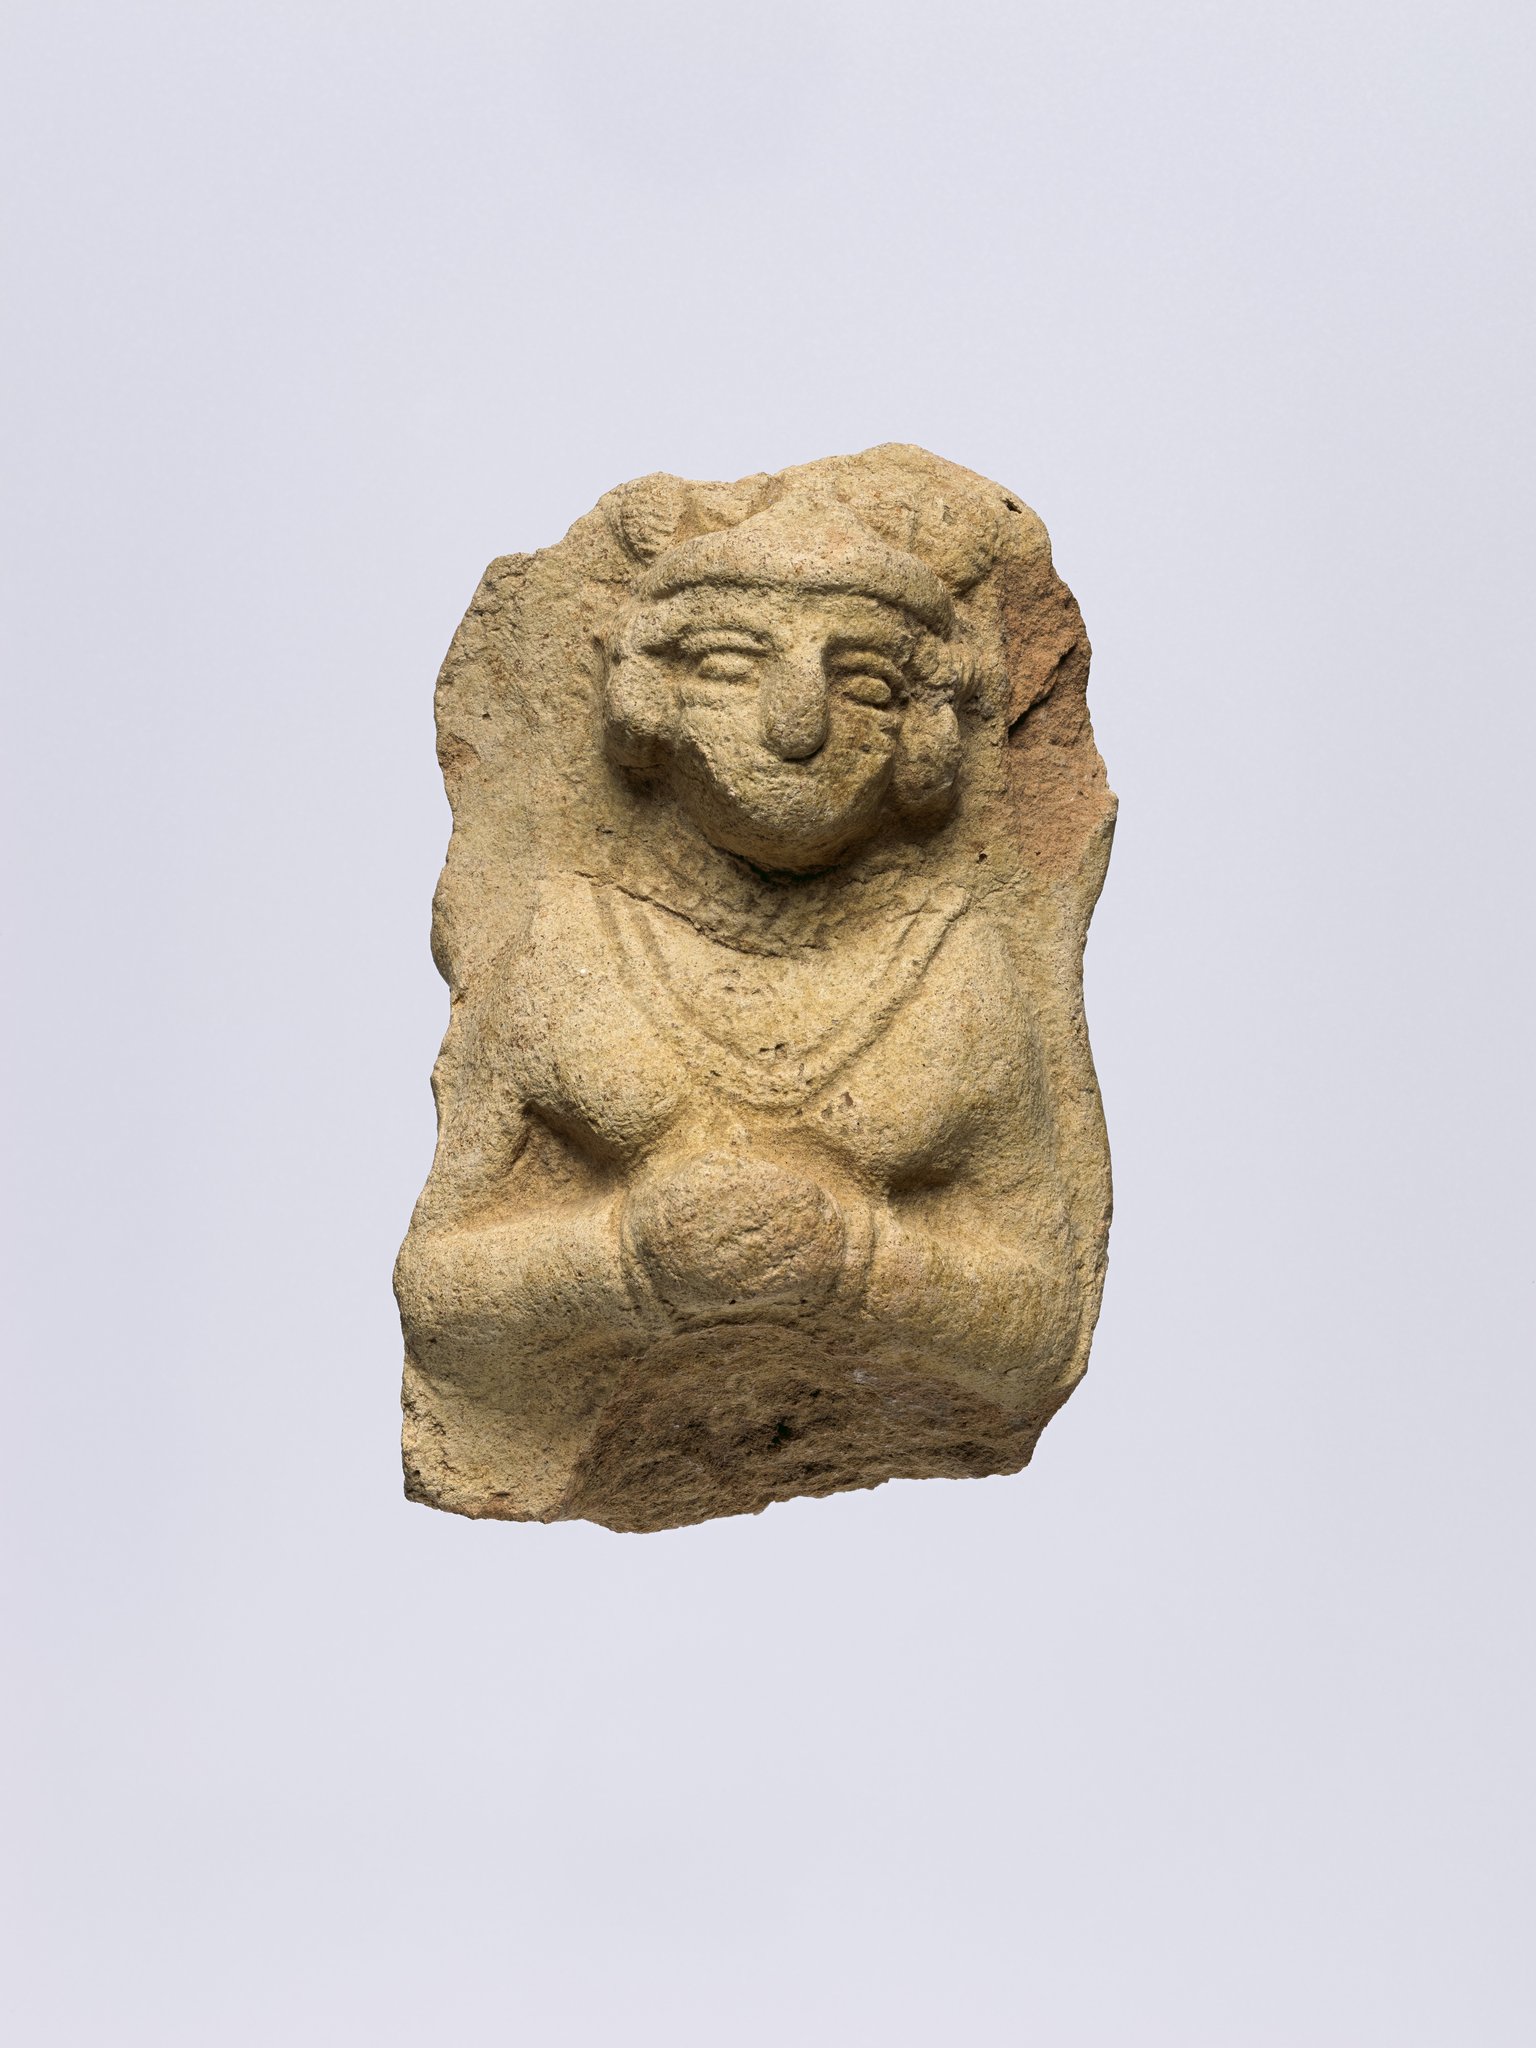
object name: sculpture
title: Female figure wearing jewelry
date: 2100-1750 BCE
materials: ceramic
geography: mesopotamia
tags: women